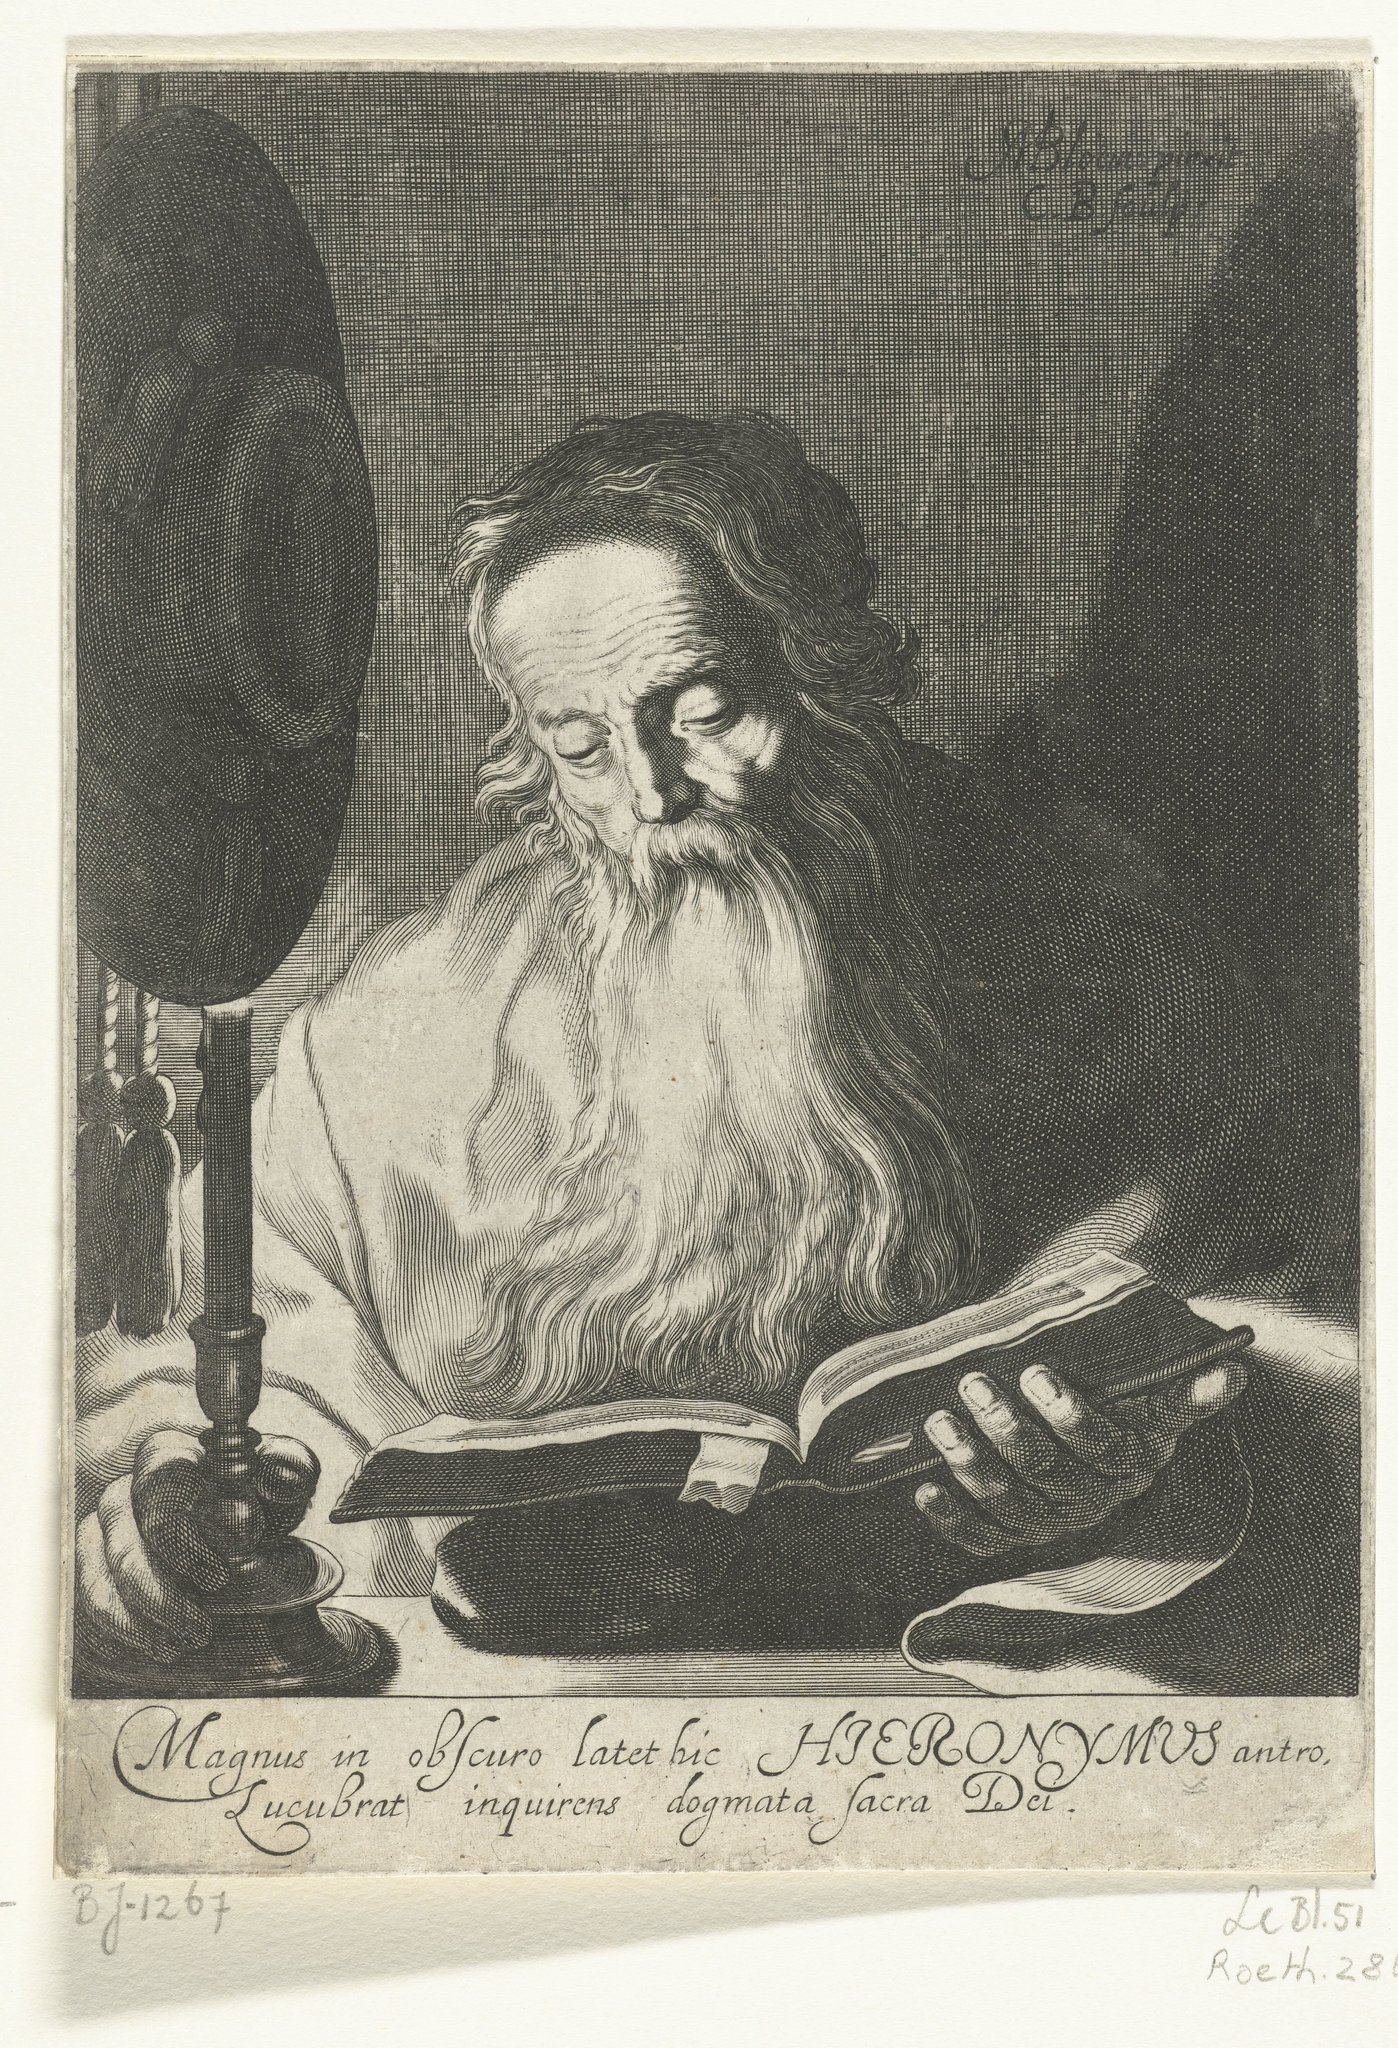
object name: print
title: De heilige Hieronymus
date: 1622-1630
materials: paper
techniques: engraving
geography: utrecht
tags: the monk and hermit jerome (hieronymus); possible attributes: book, cardinal's hat, crucifix, hour-glass, lion, skull, stone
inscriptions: collector's mark: Lugt 240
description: De heilige Hieronymus leest in een boek bij kaarslicht. Aan de muur hangt zijn attribuut de kardinaalshoed.